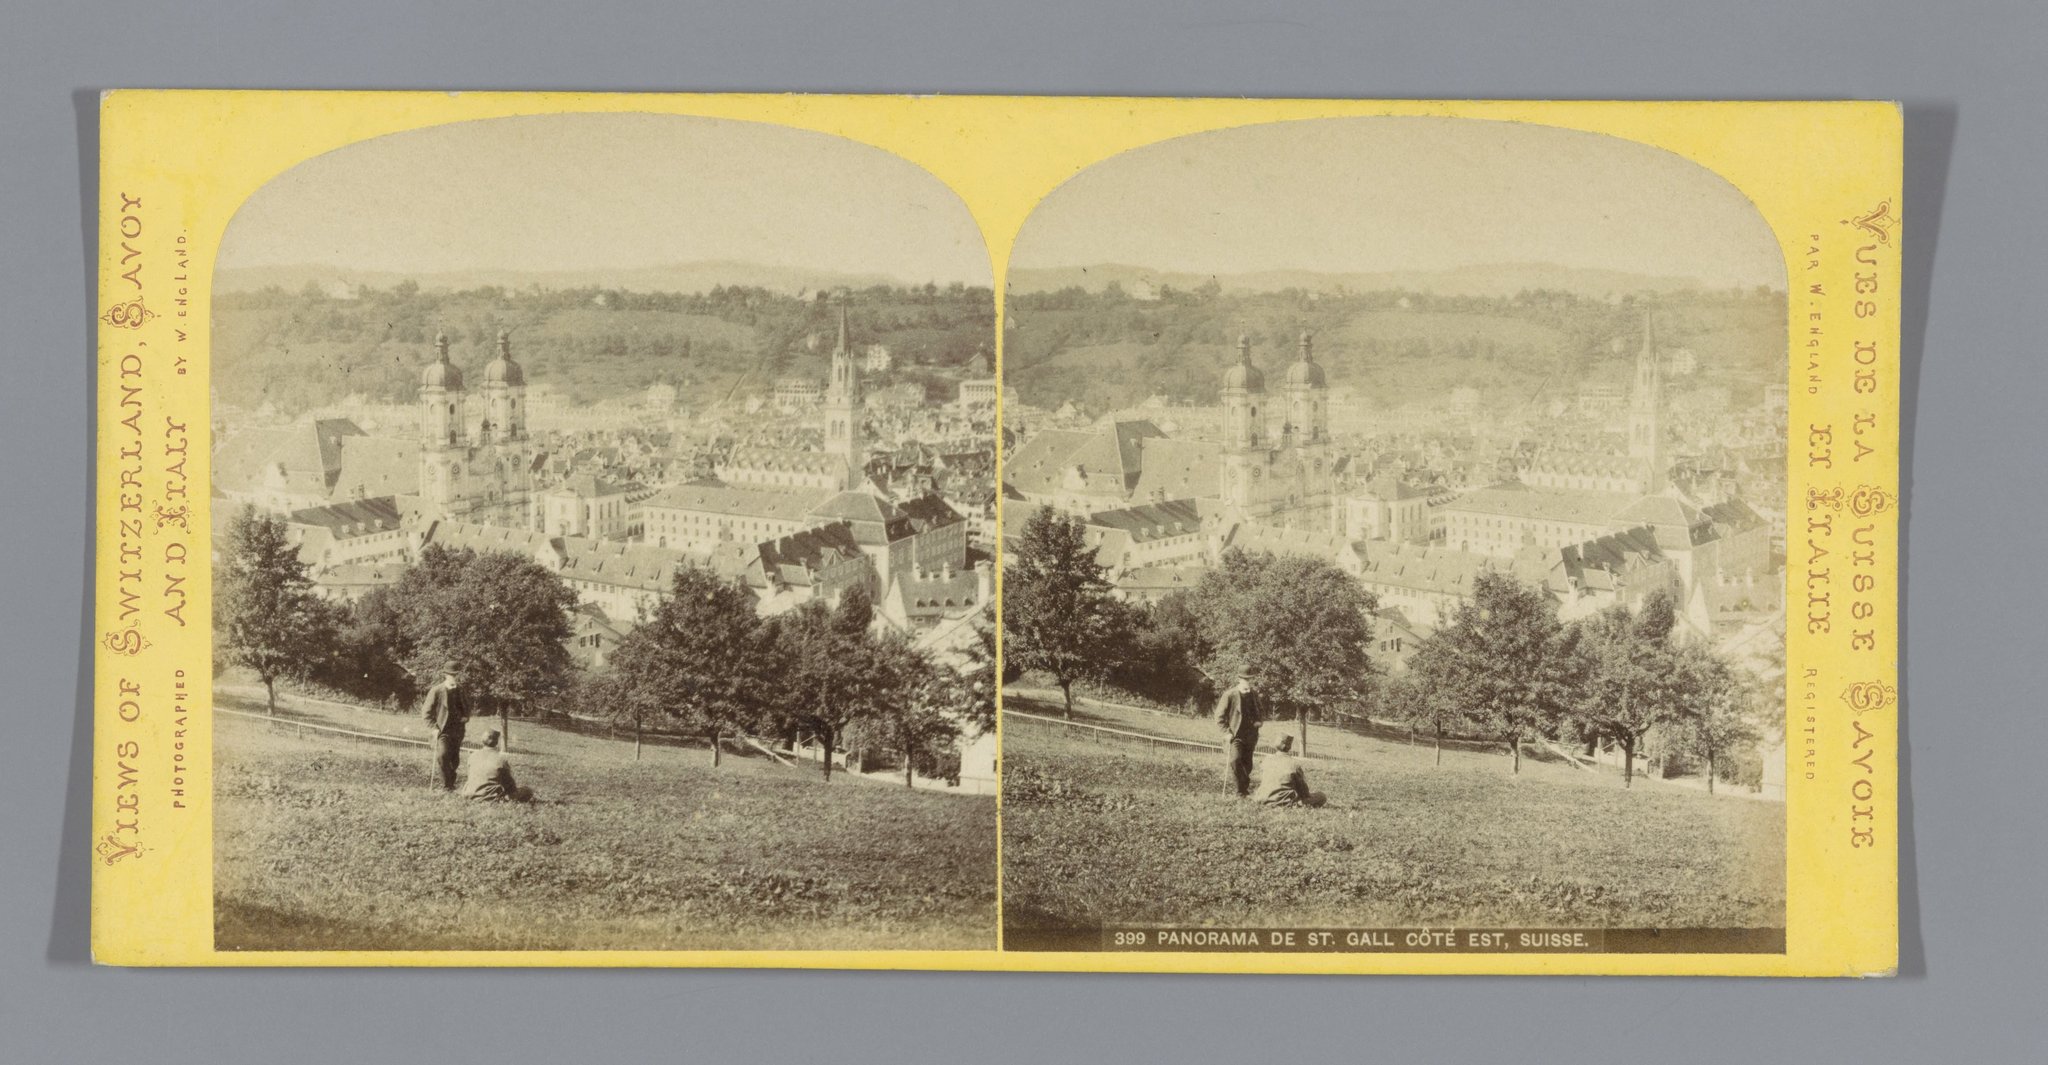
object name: stereograph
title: Panorama de St Gall côté est, Suisse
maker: william england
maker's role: fotograaf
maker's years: 1816-1896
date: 1850-1880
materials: cardboard, photographic support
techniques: albumen print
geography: sankt gallen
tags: prospect of city, town panorama, silhouette of city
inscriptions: inscription: ‘Vues de la Suisse Savoie et Italie’, number: ‘399’